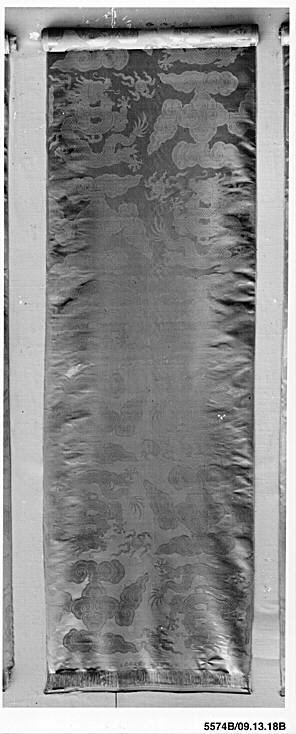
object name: do not use this record duplicate of 09. 13. 18a d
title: Piece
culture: chinese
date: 1801-1900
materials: silk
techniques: weave